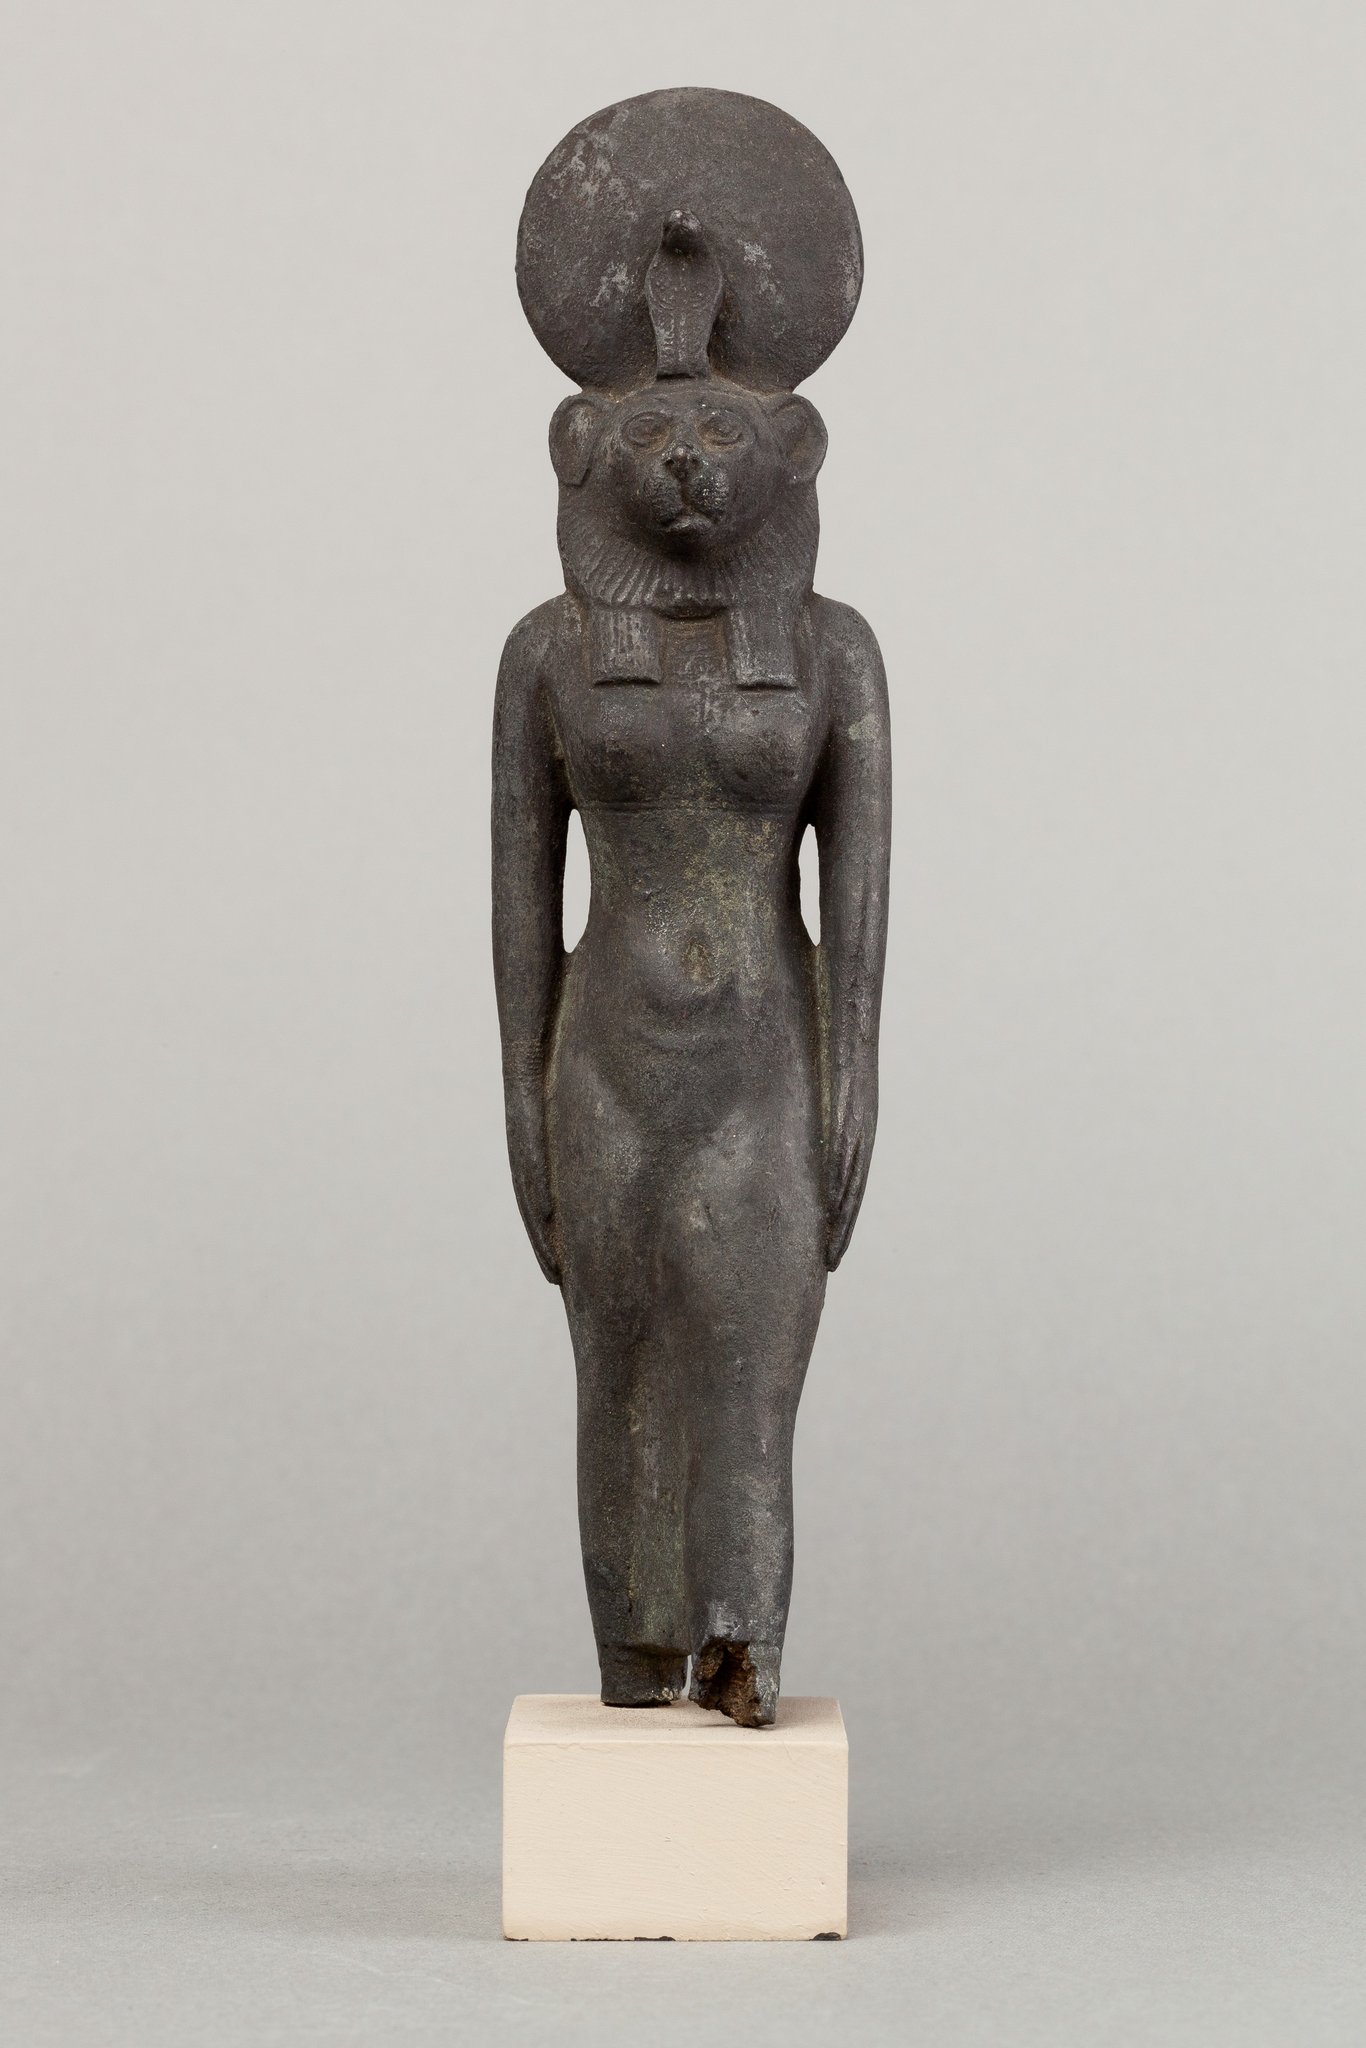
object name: statuette, lion headed goddess, wadjet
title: A lion headed goddess, possibly Wadjet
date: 664-630 BCE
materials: metal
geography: egypt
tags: sekhmet